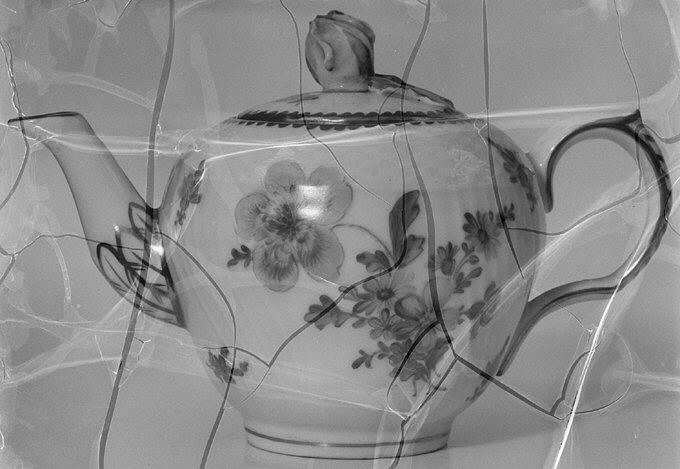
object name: teapot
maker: royal porcelain manufactory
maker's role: factory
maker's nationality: danish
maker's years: 1775-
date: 1801-1900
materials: hard paste porcelain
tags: flowers